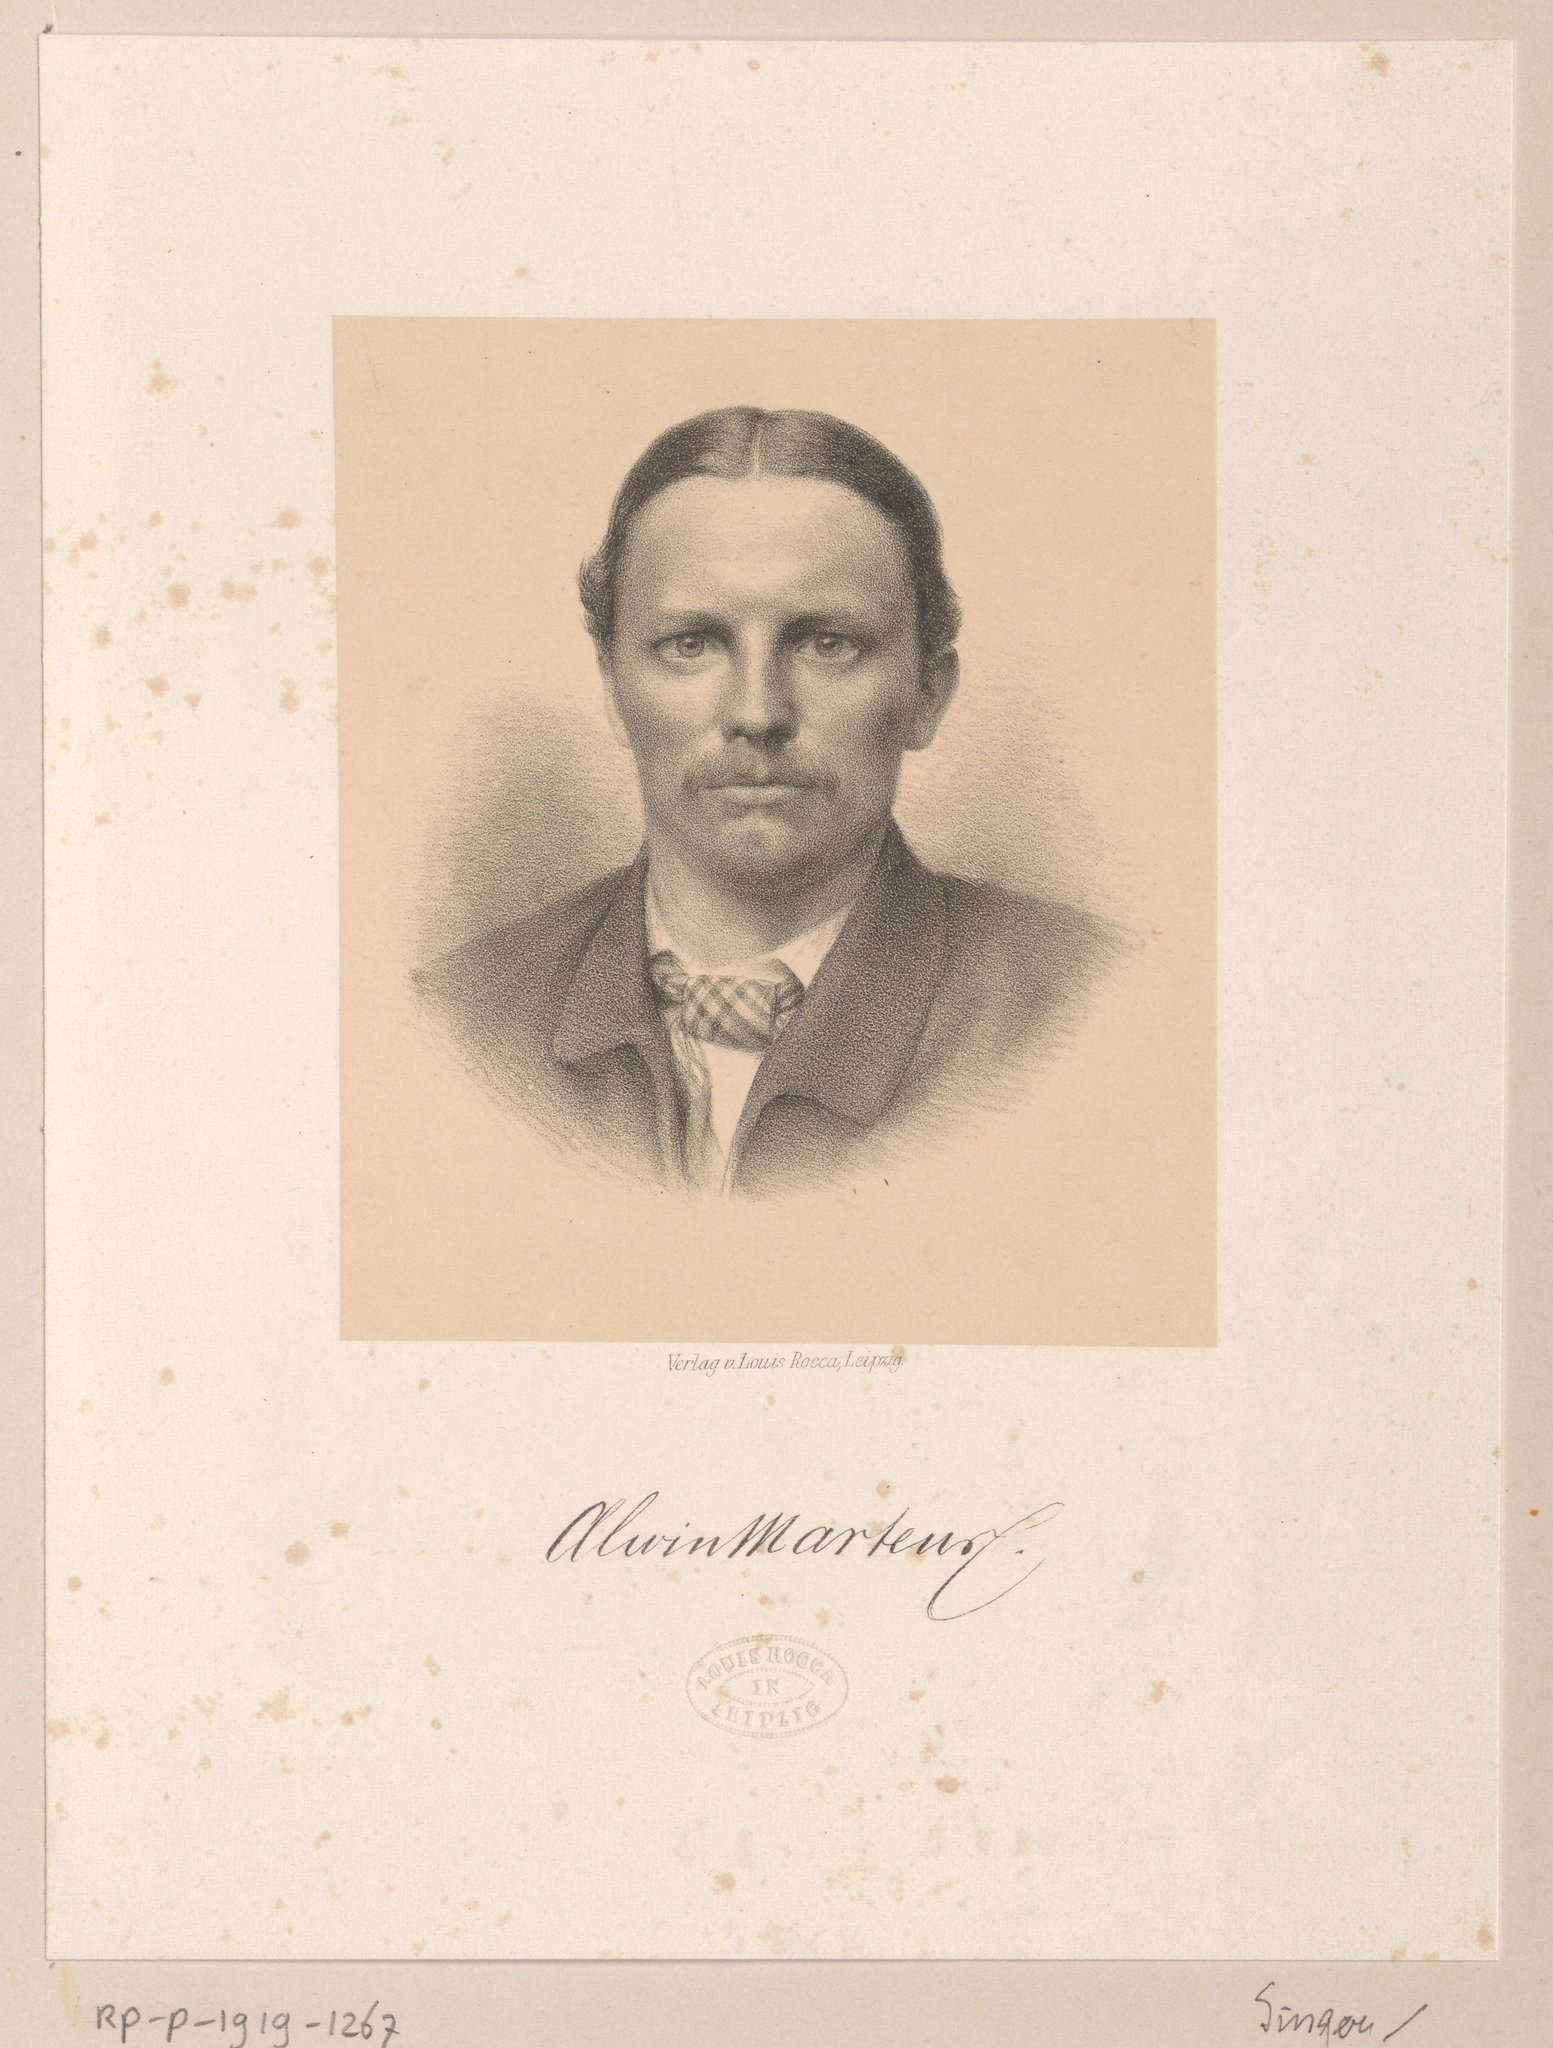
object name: print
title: Portret van Alwin Martens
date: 1850-1870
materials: paper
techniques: lithograph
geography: germany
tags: historical persons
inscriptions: collector's mark: Lugt 2228, check stamp: ‘Louis Rocca in Leipzig’